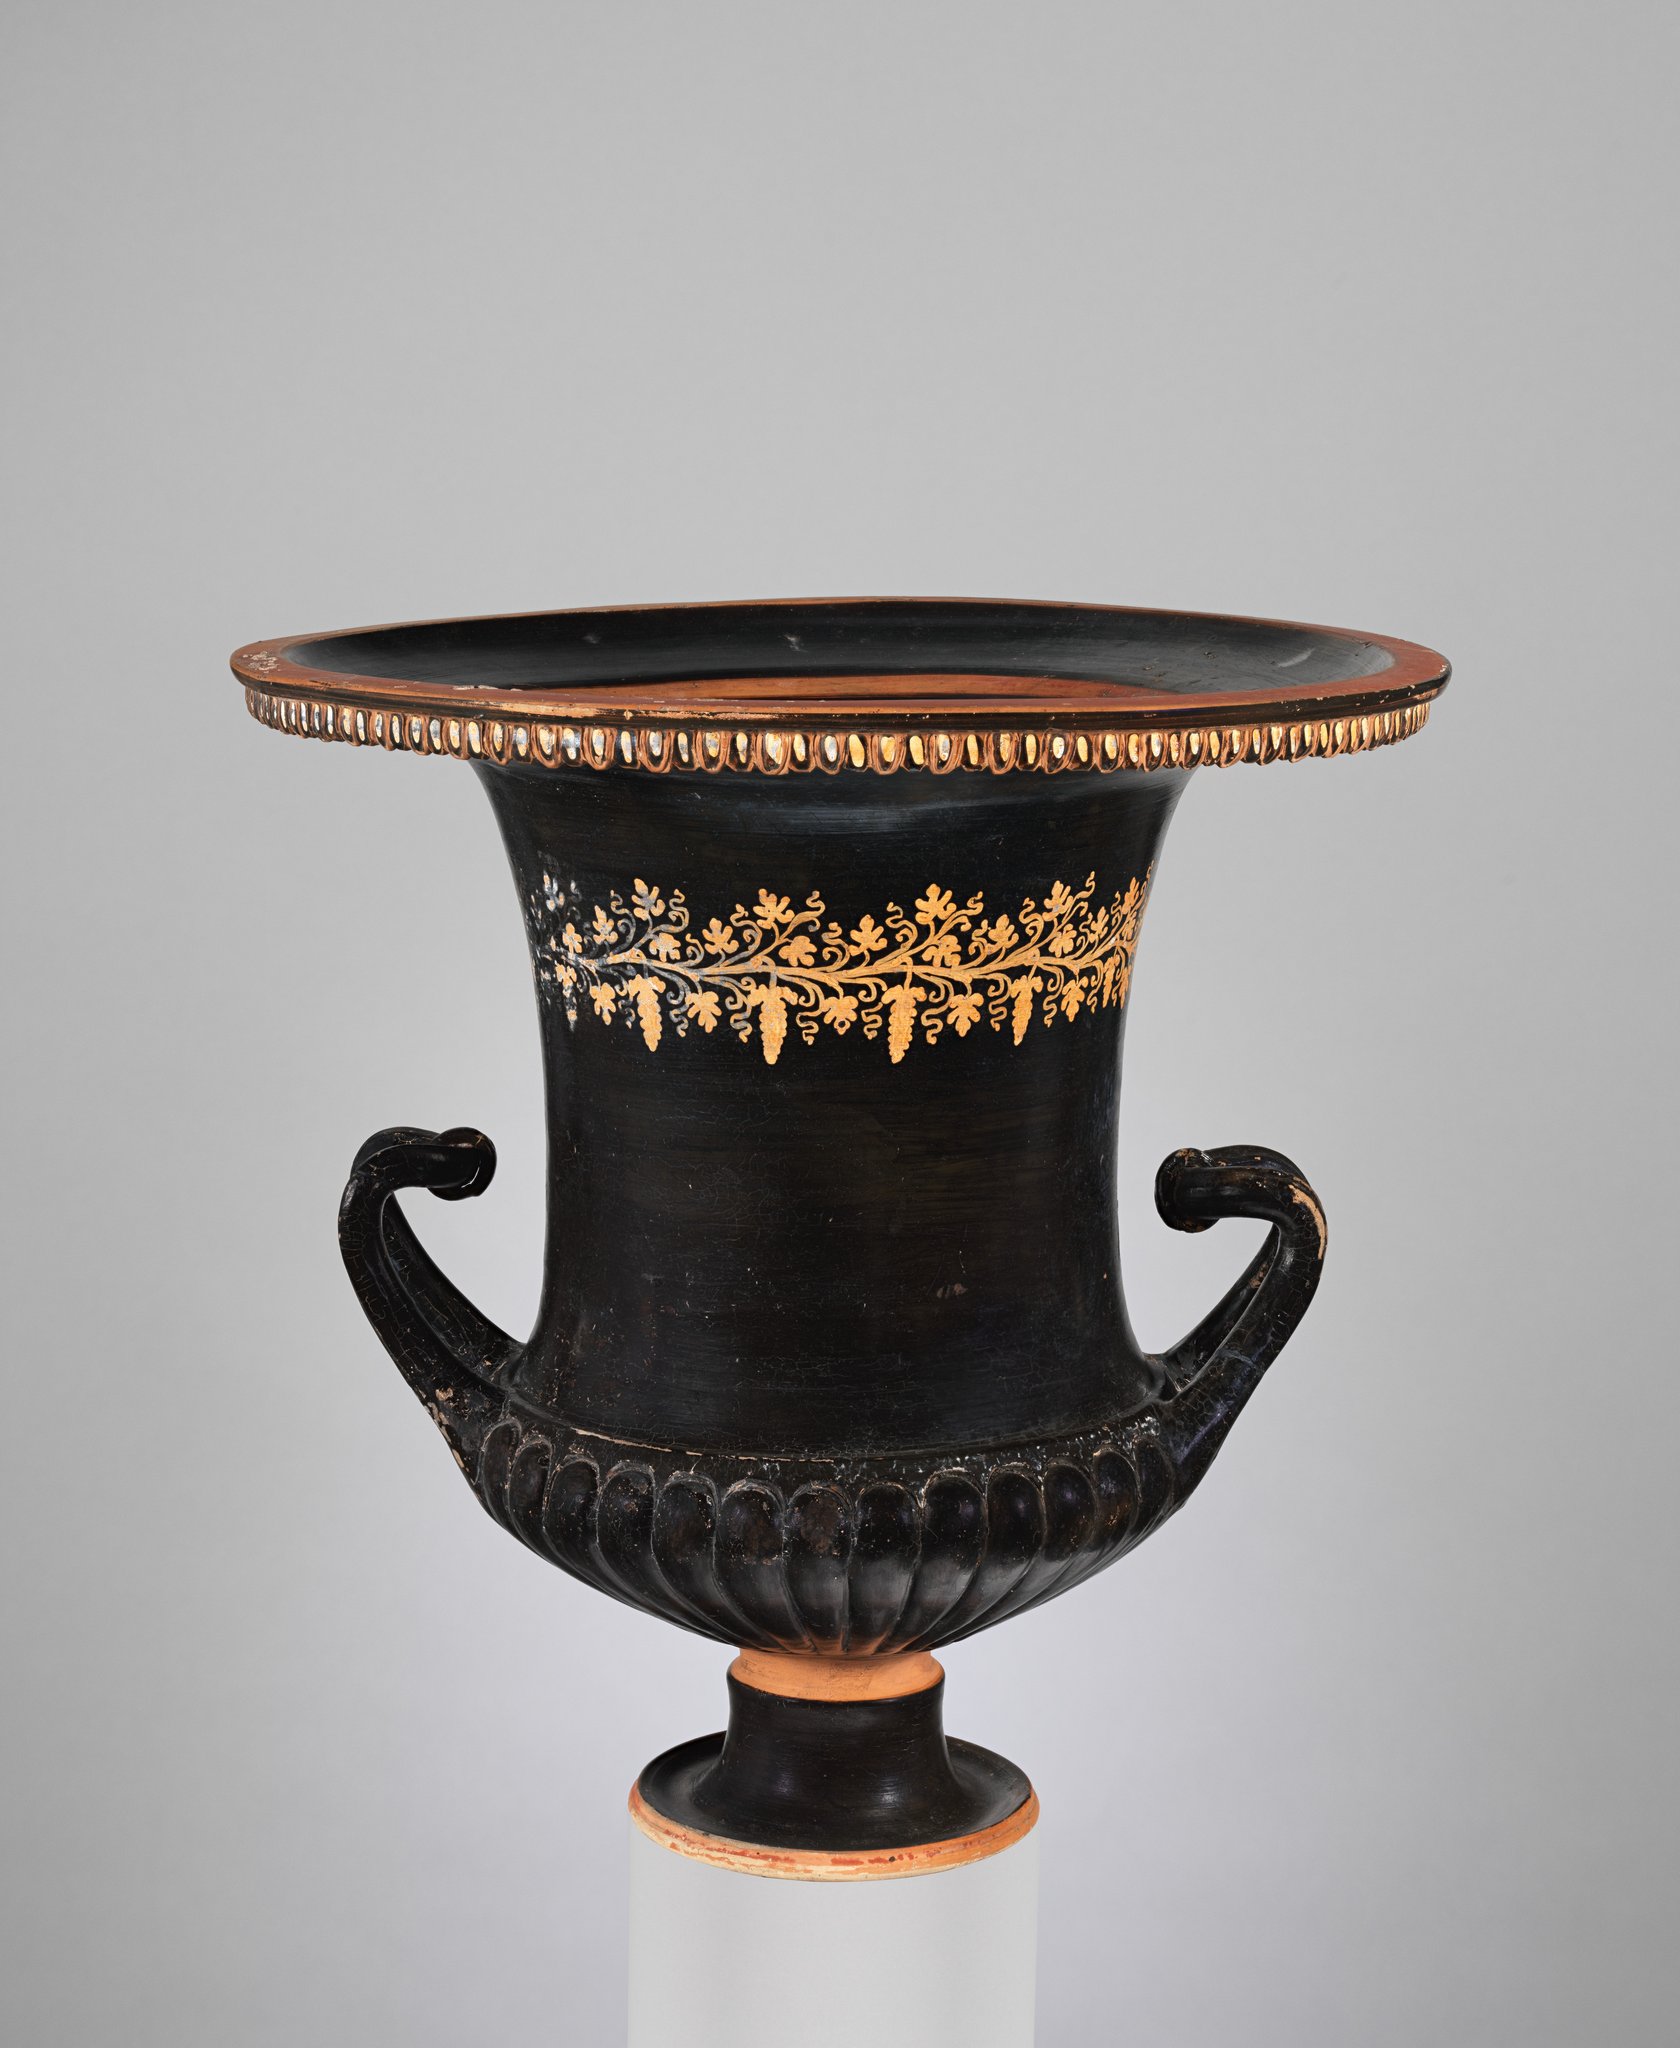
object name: calyx krater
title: Terracotta calyx-krater (mixing bowl)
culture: greek, south italian, apulian, gnathian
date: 350-300 BCE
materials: terracotta